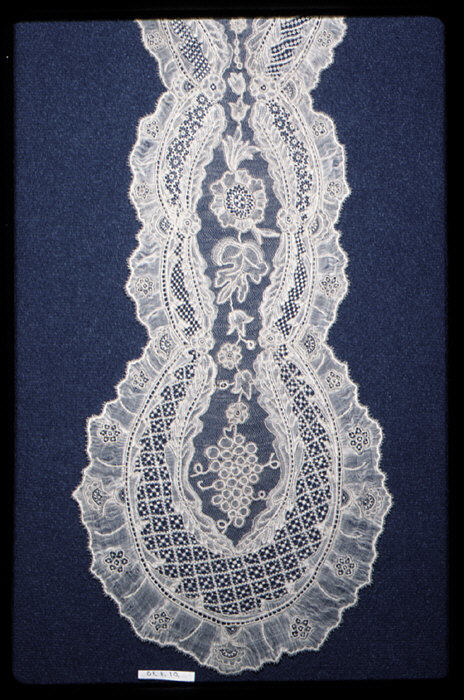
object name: barbe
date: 1801-1900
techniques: lace